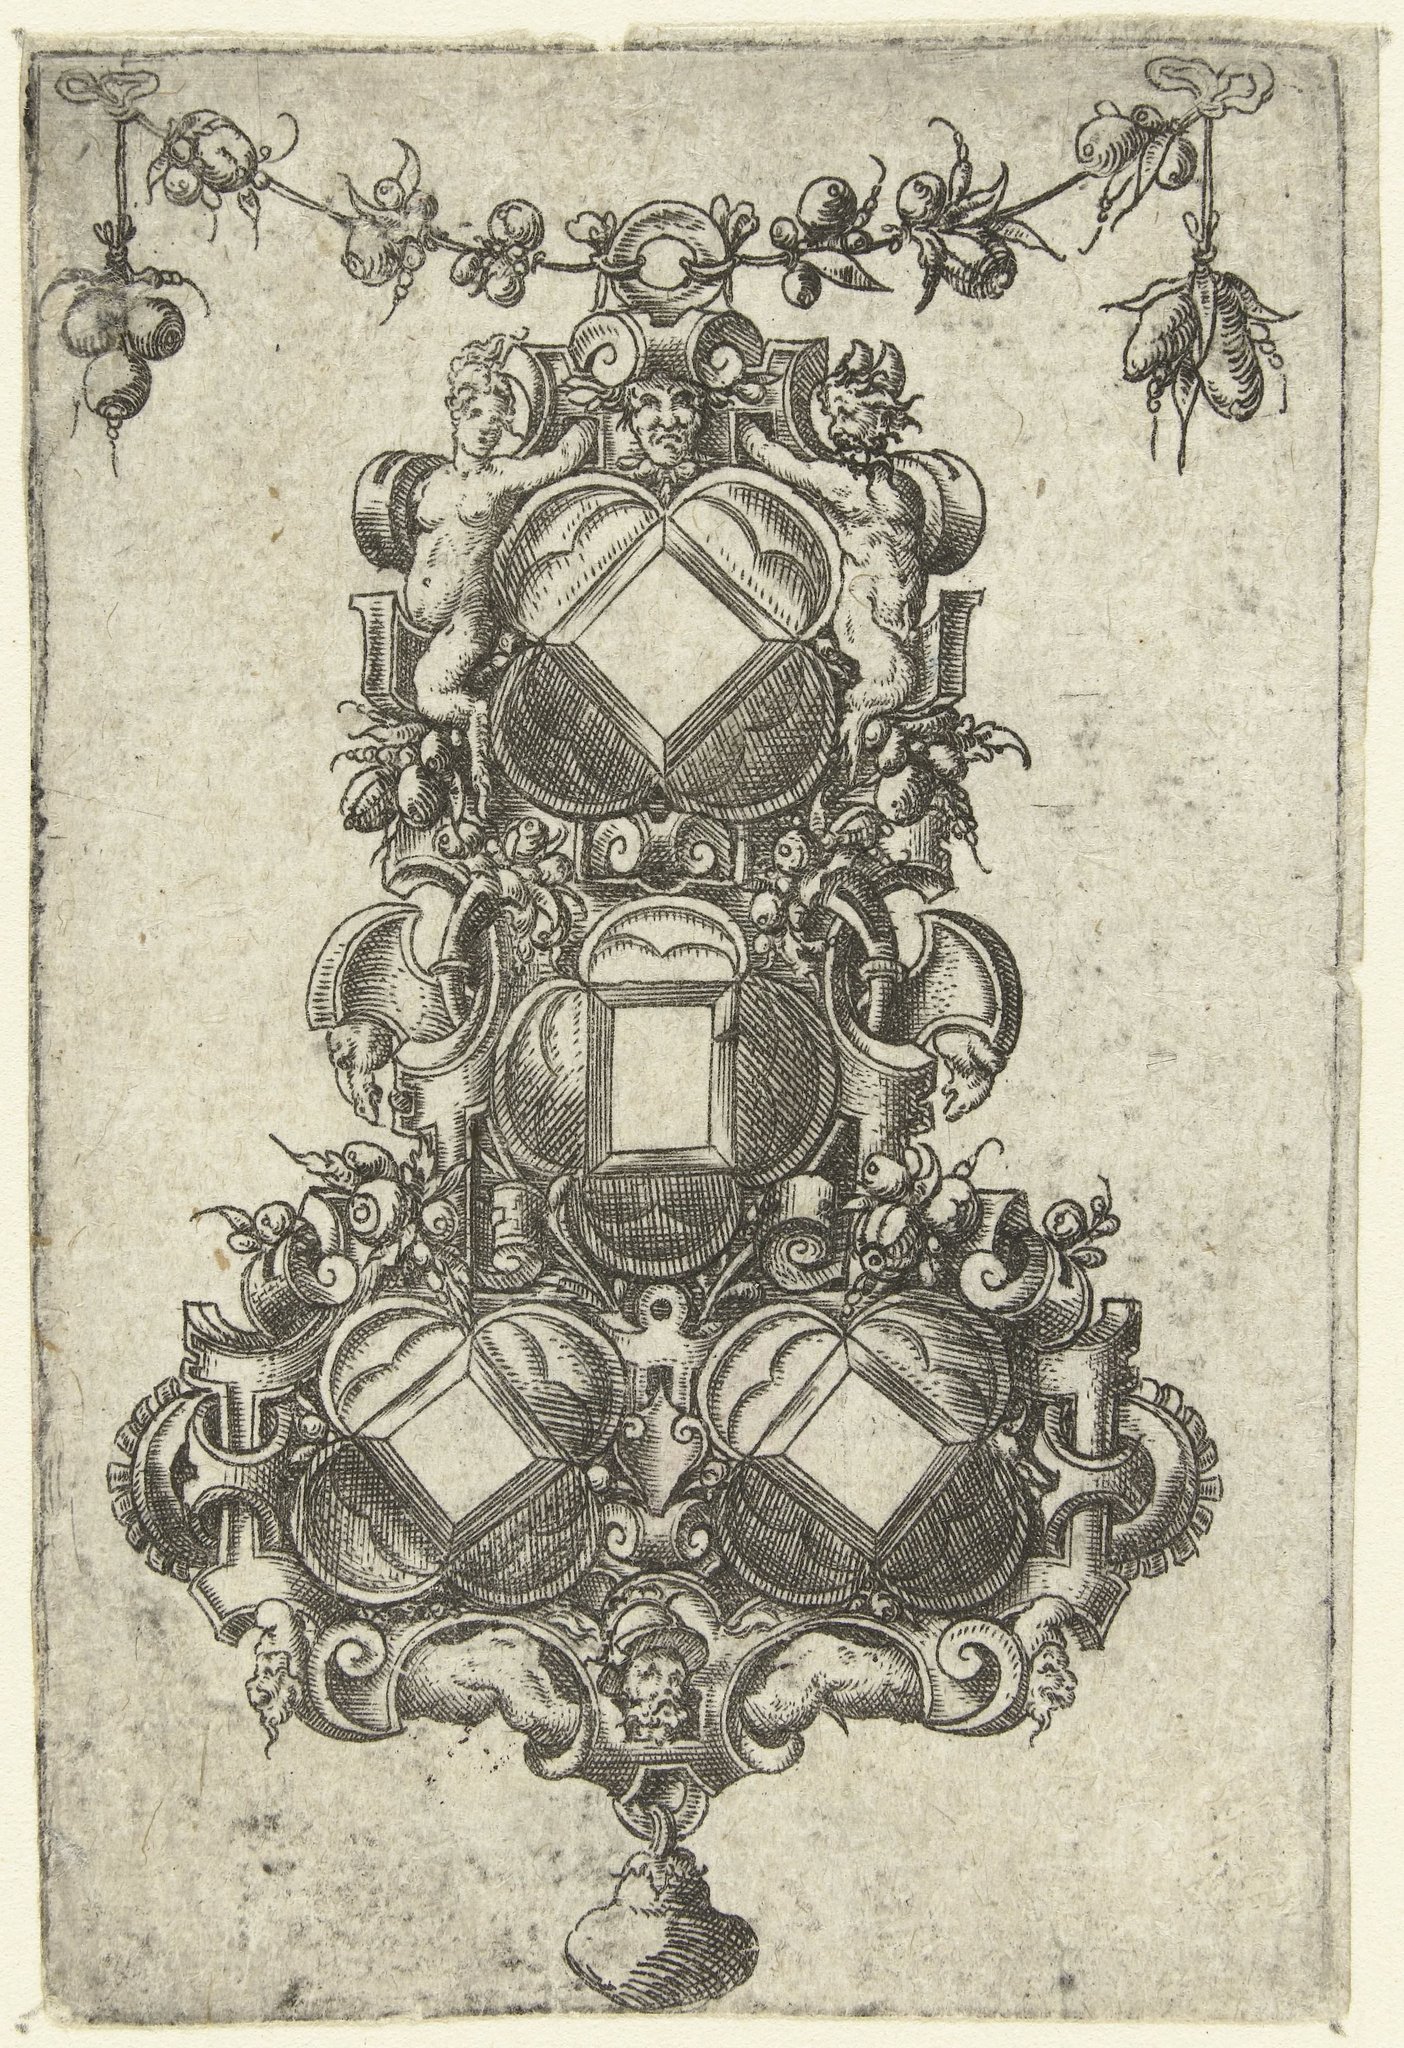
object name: print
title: Ontwerpen voor hangers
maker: Anonymous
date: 1508-1572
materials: paper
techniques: engraving, etching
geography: germany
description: Linksboven staat in het rolwerk een vrouwelijke sater en rechtsboven een mannelijke. Aan de onderzijde van de hanger hangen twee mannen met mutsen op languit voorover in het rolwerk. Eén van vijf bladen met edelstenen en parels in zettingen van rolwerk en grotesken.